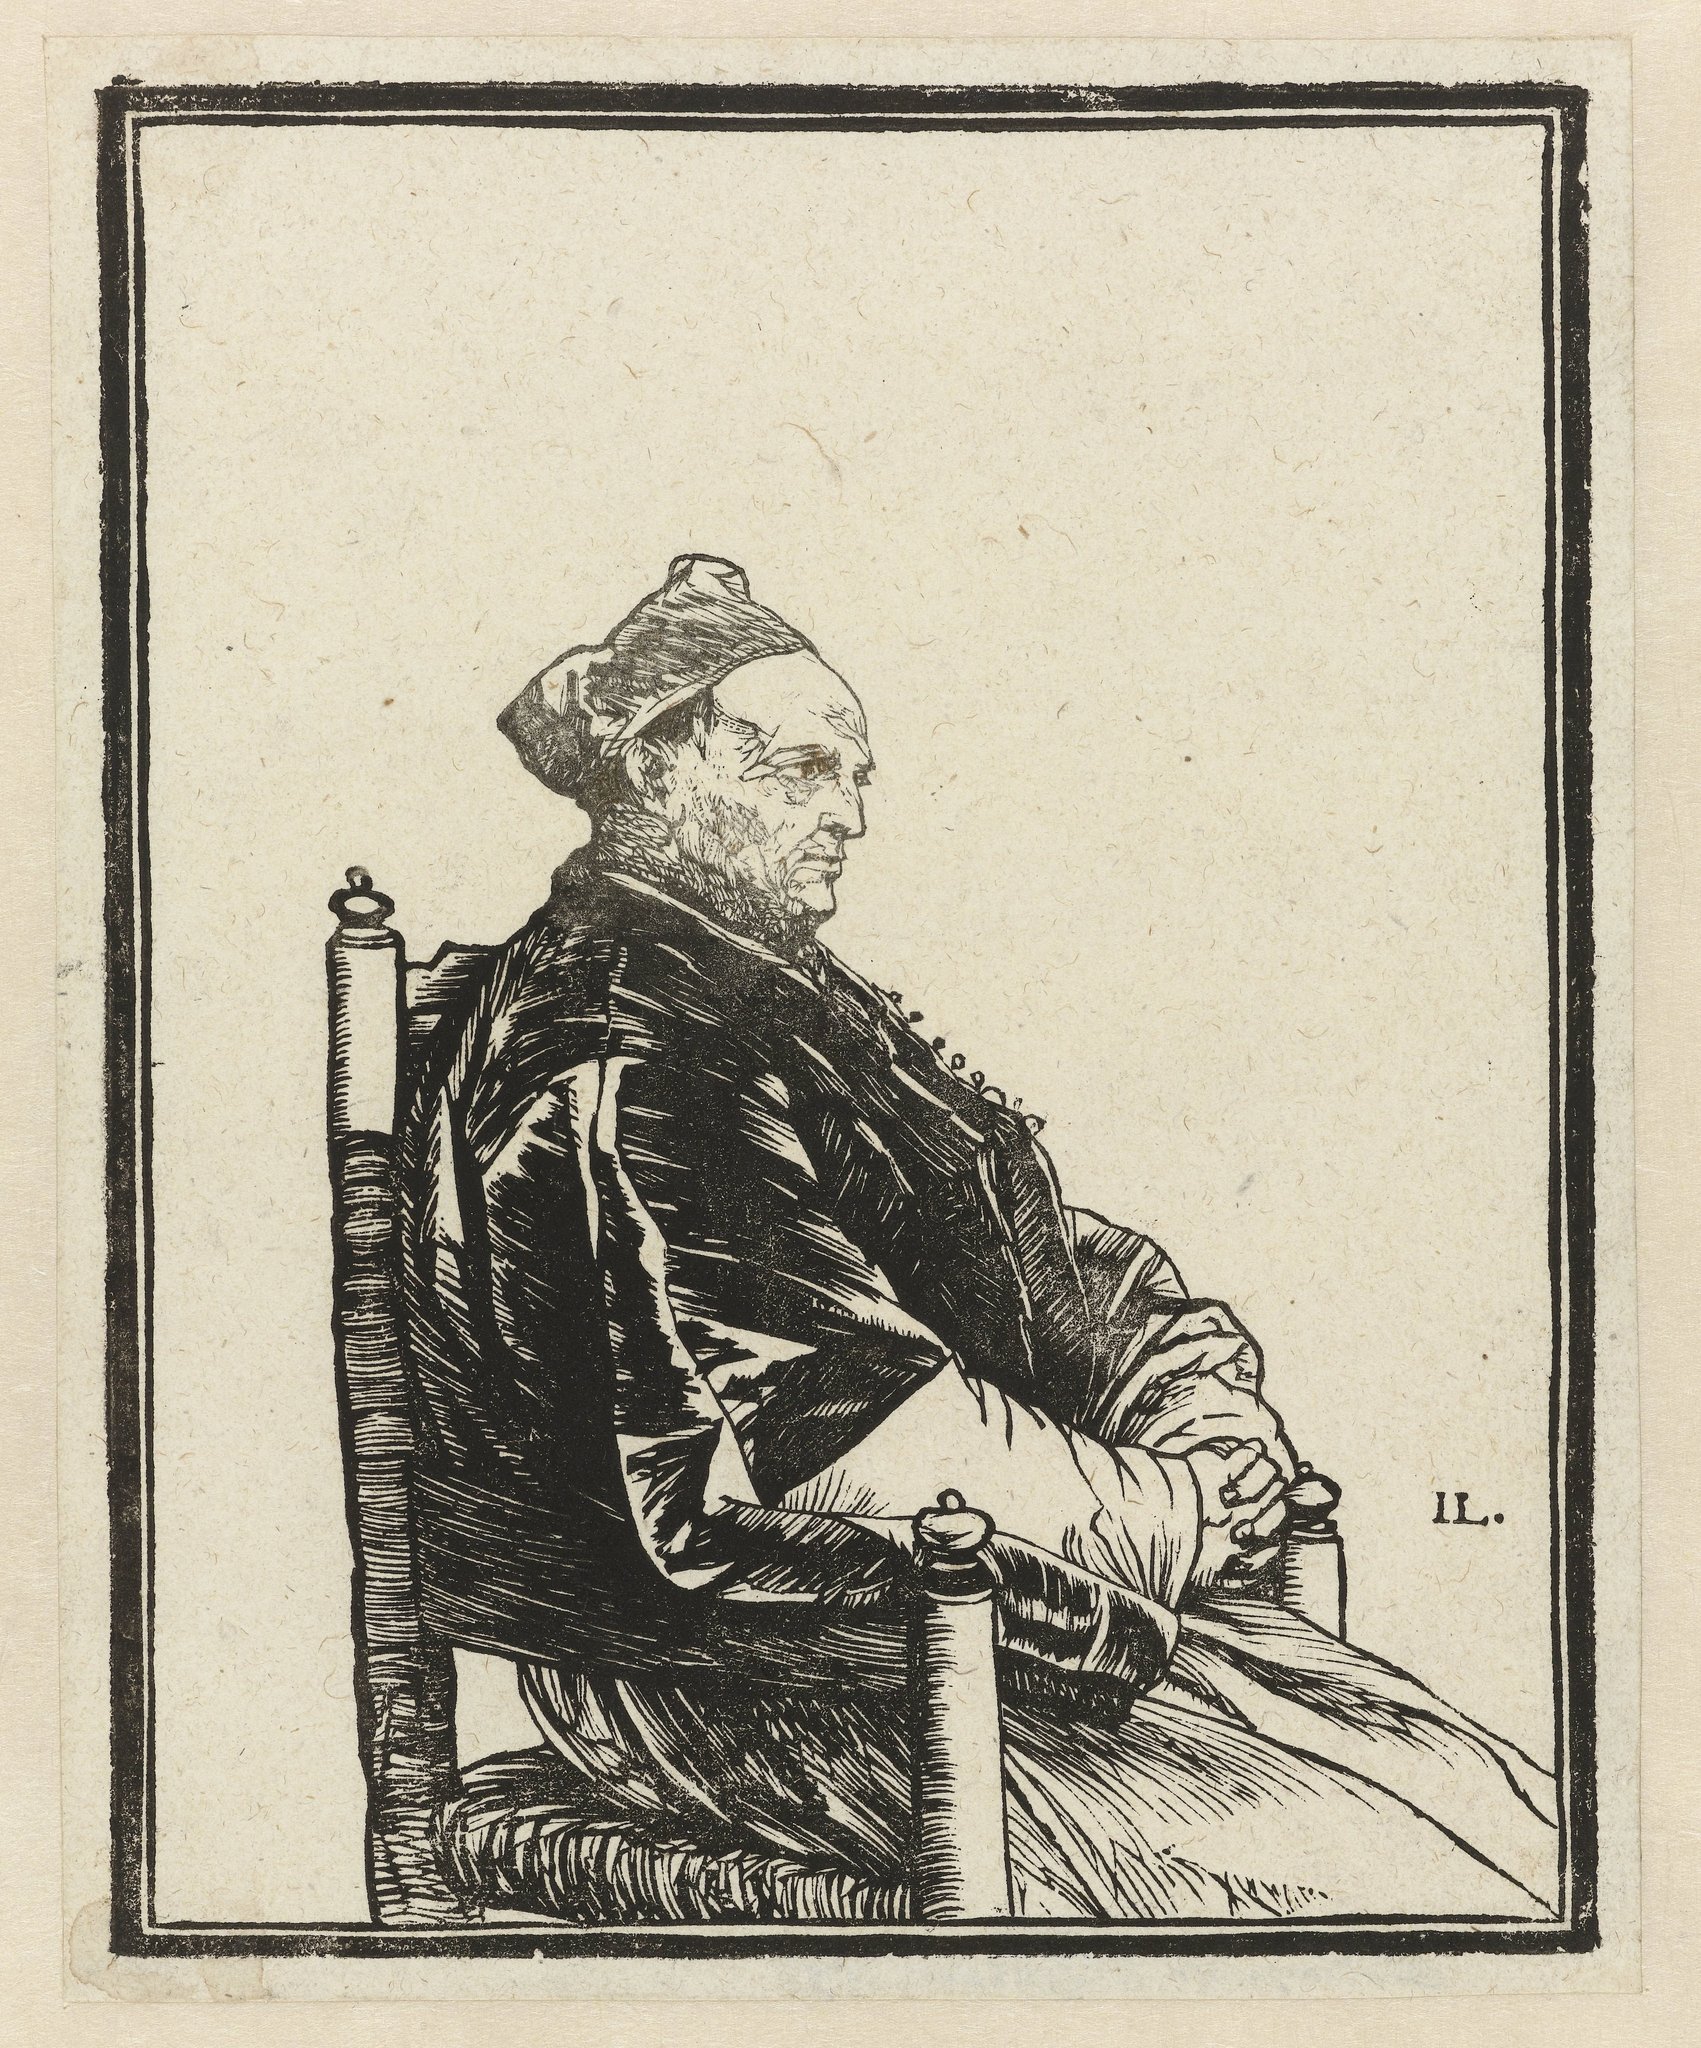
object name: print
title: Portret van een zittende geestelijke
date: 1625-1674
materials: paper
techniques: woodcut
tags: organization, functionaries and dignitaries in roman catholic church; clergy in general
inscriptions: collector's mark: Lugt 240